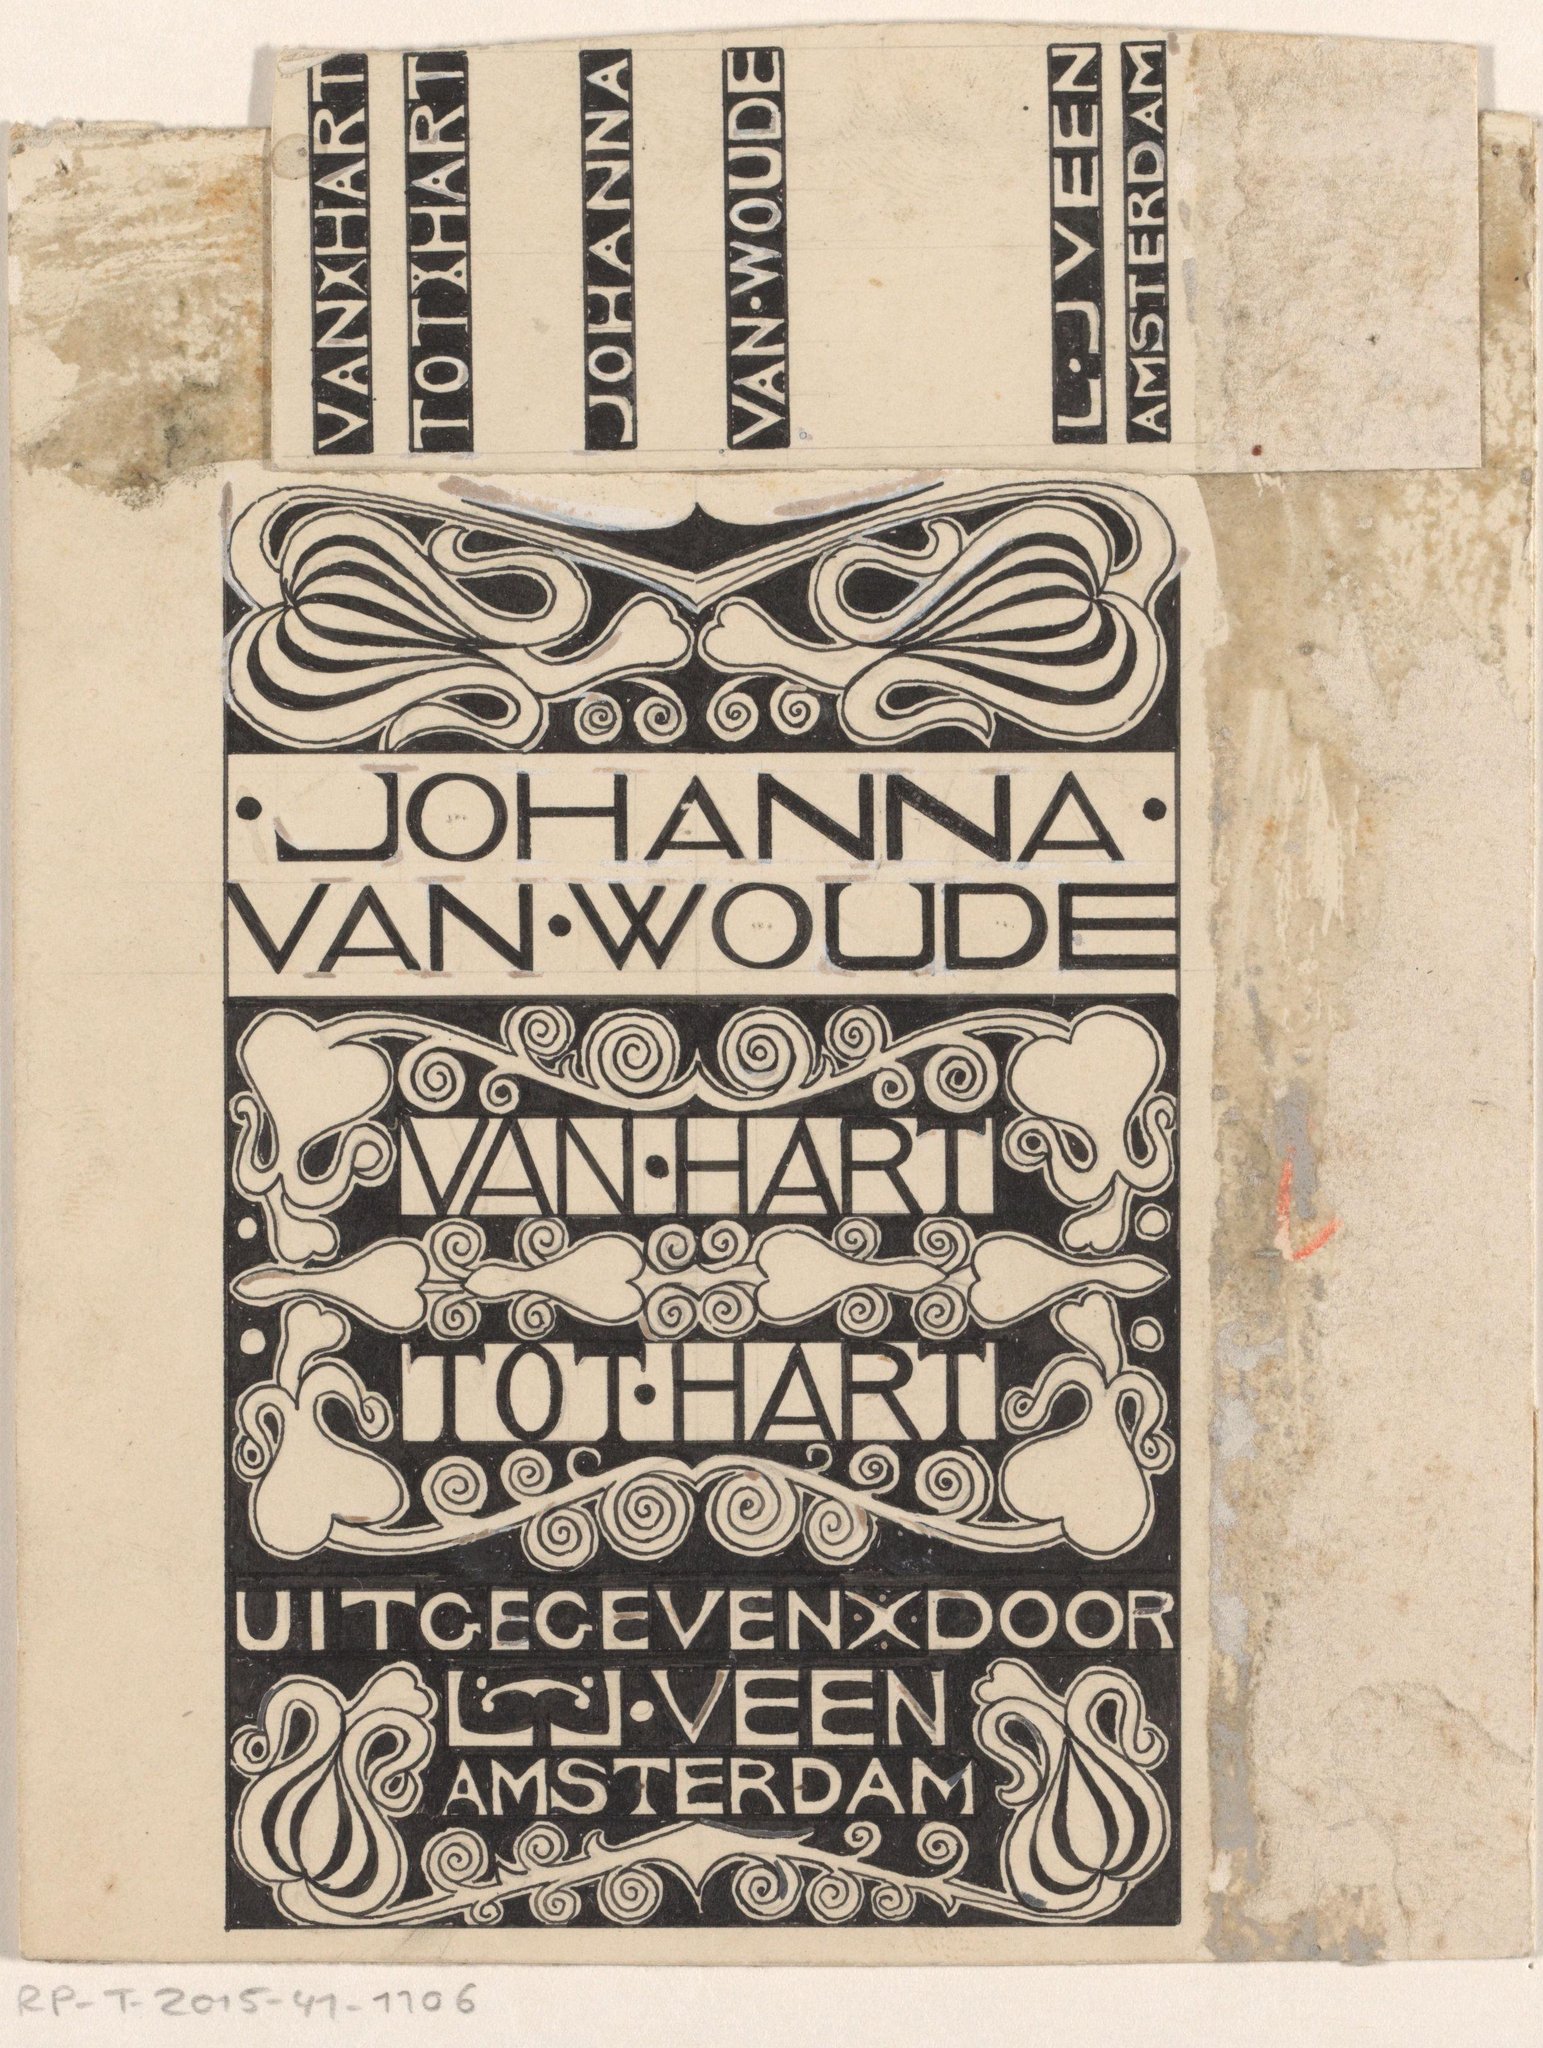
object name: drawing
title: Bandontwerp voor: Johanna van Woude, Van hart tot hart, 1900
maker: theo neuhuys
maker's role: draughtsman, print maker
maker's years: 1878-1921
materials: cardboard, paint, ink, pencil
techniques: brush, pen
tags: ornaments ~ art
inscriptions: :, collector's mark: Lugt 2228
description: Ontwerp voor een boekband en -rug met ornamentele versiering.